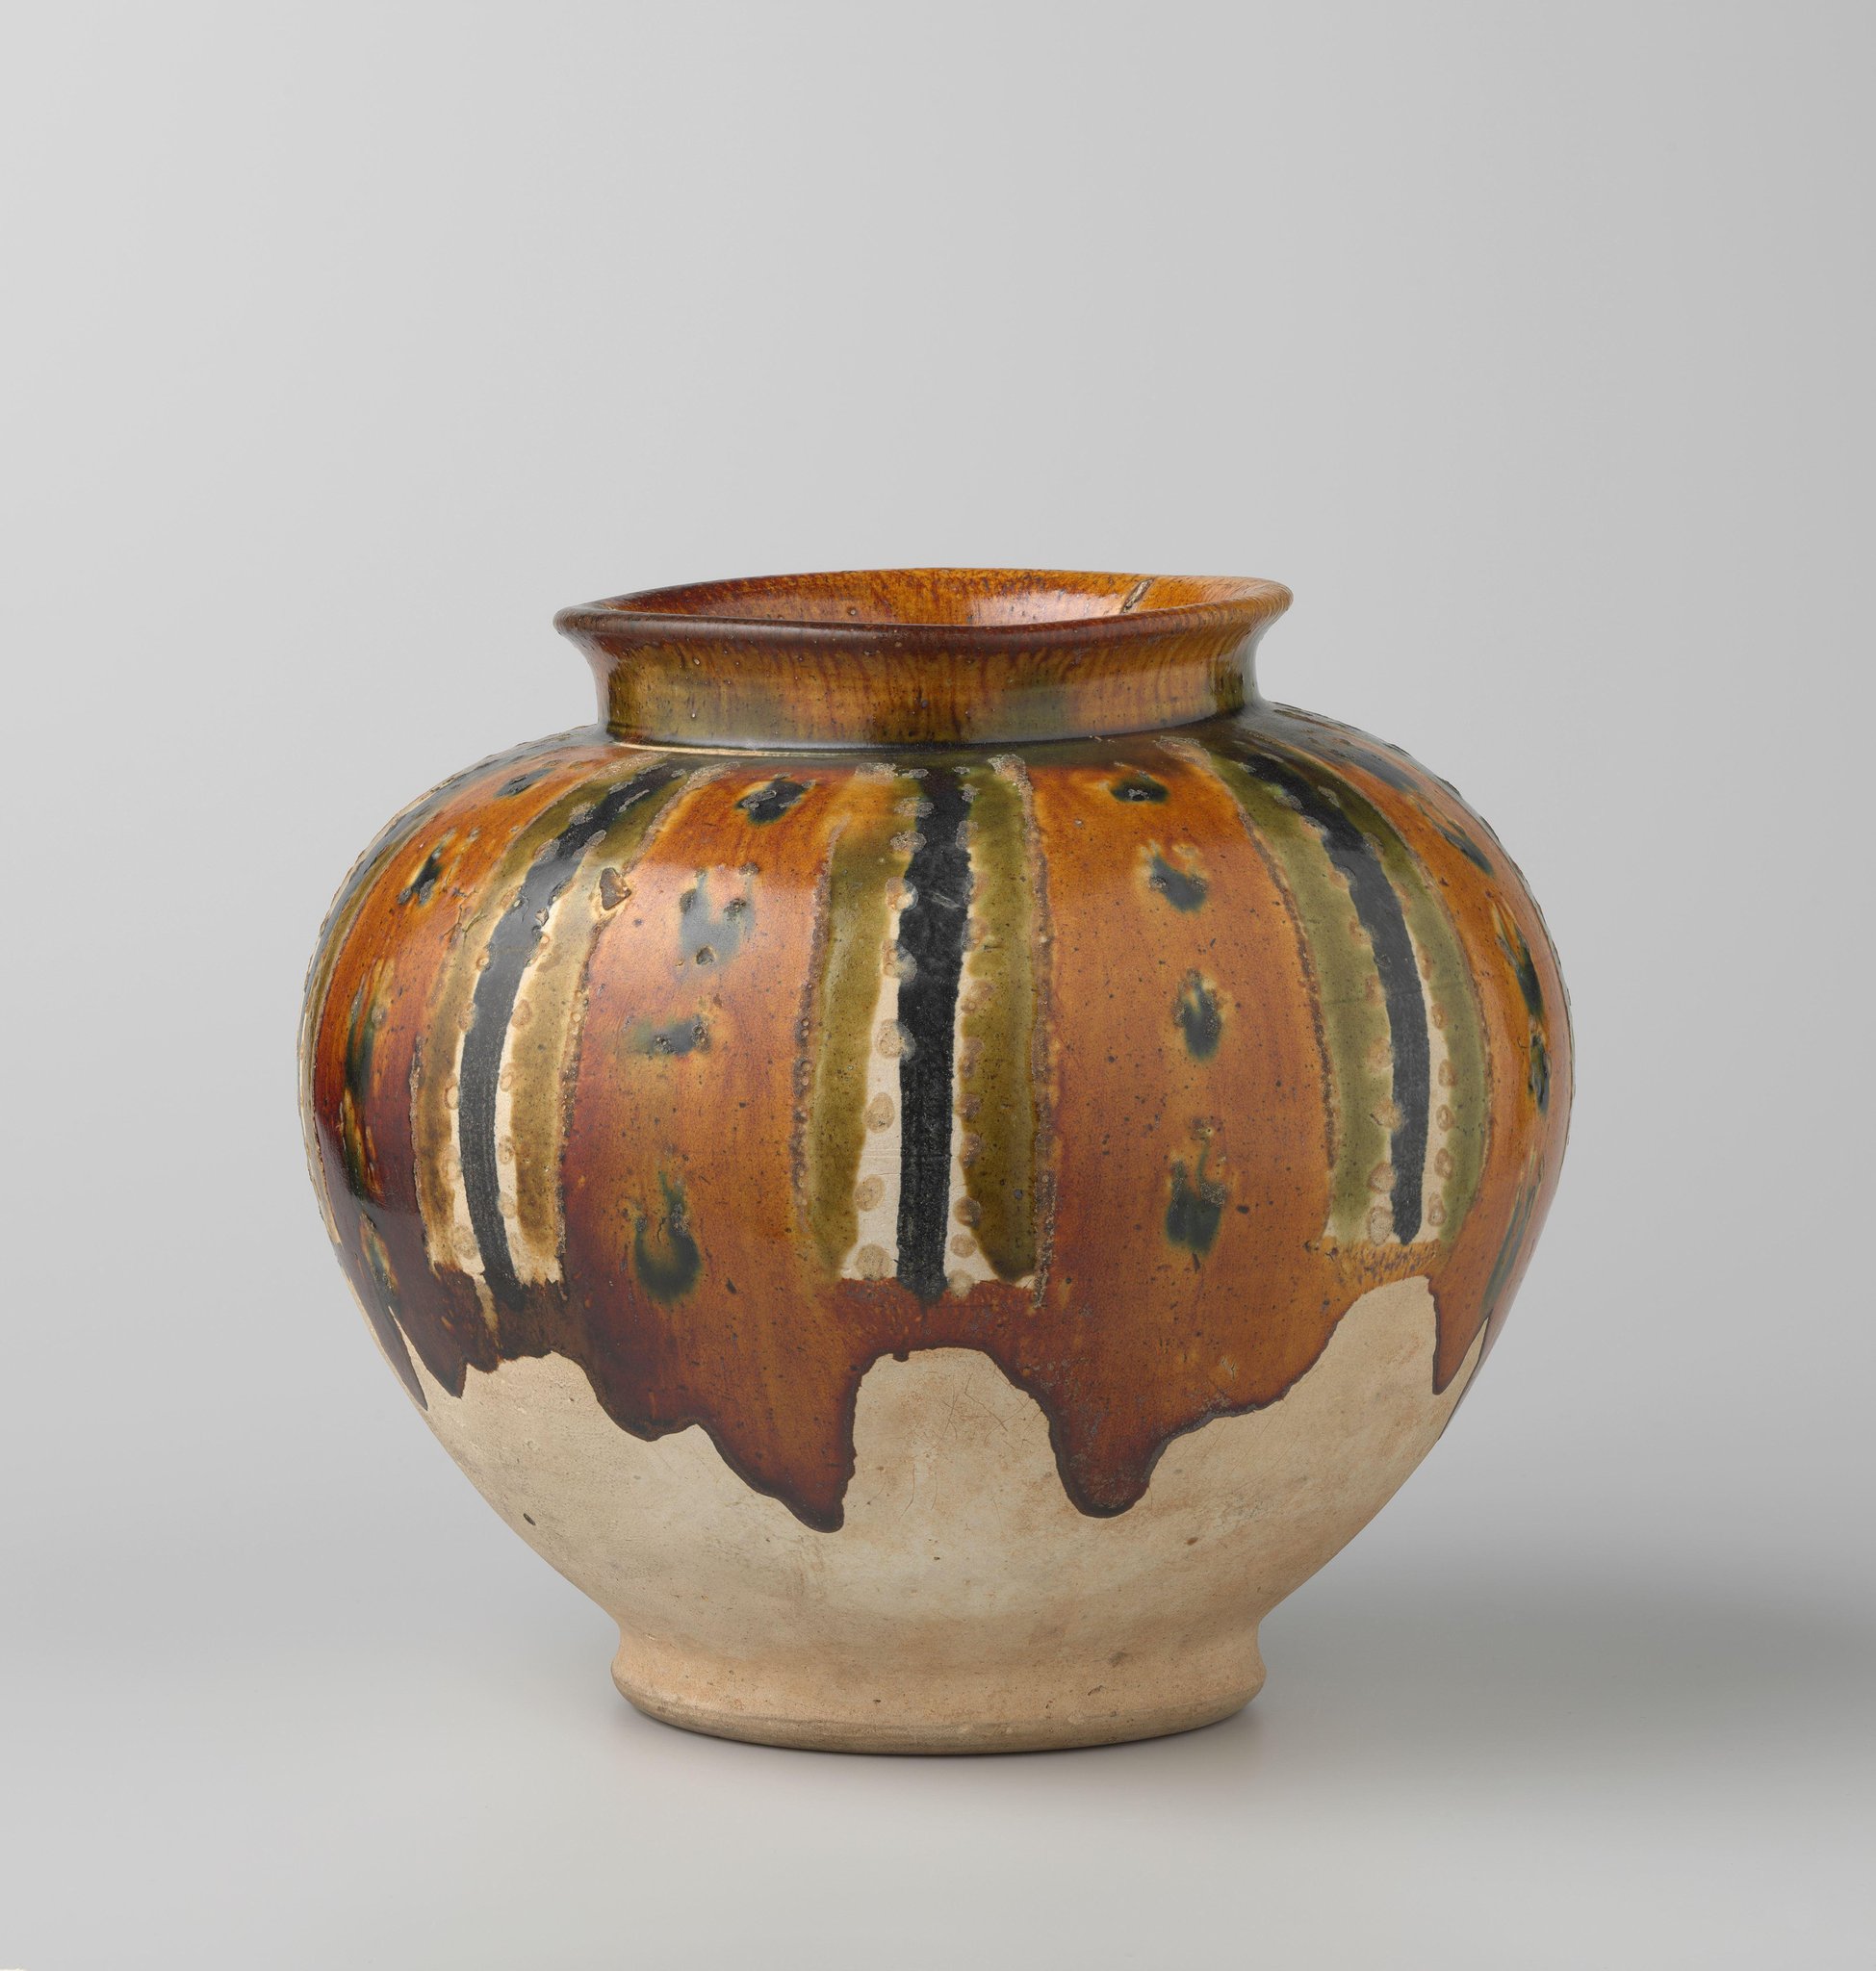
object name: pot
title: Pot met sancai glazuur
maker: Anonymous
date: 618-960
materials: ceramic, earthenware, stoneware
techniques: vitrification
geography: china